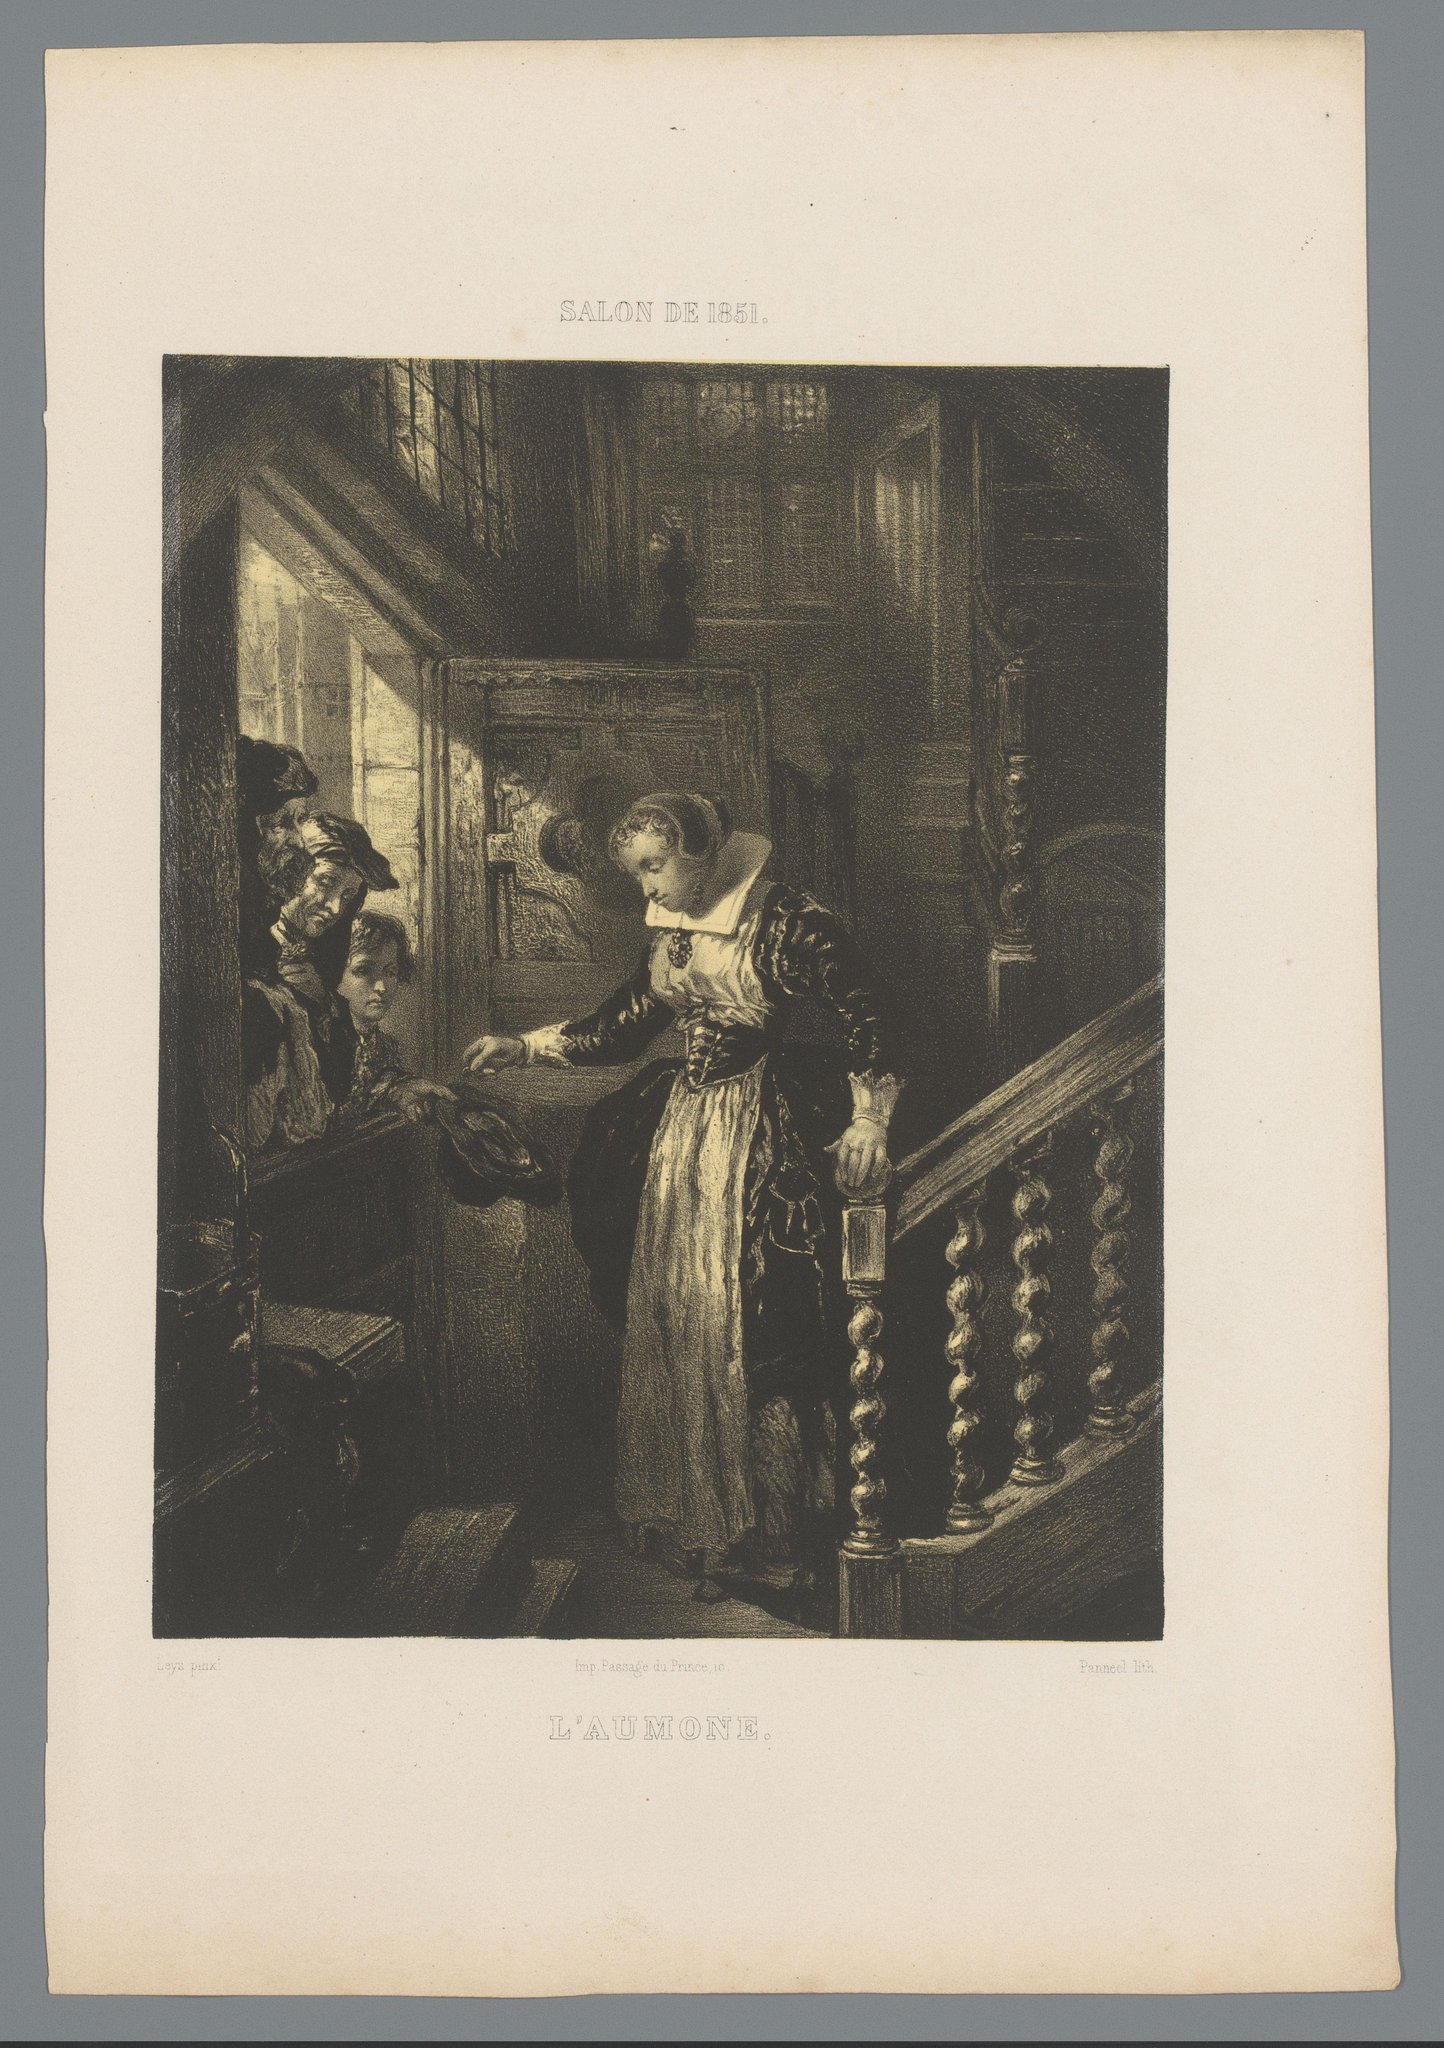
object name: print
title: Vrouw geeft een aalmoes aan de deur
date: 1851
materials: paper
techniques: tone lithography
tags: giving alms or other charity, e.g.: handing out food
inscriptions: collector's mark: Lugt 2228